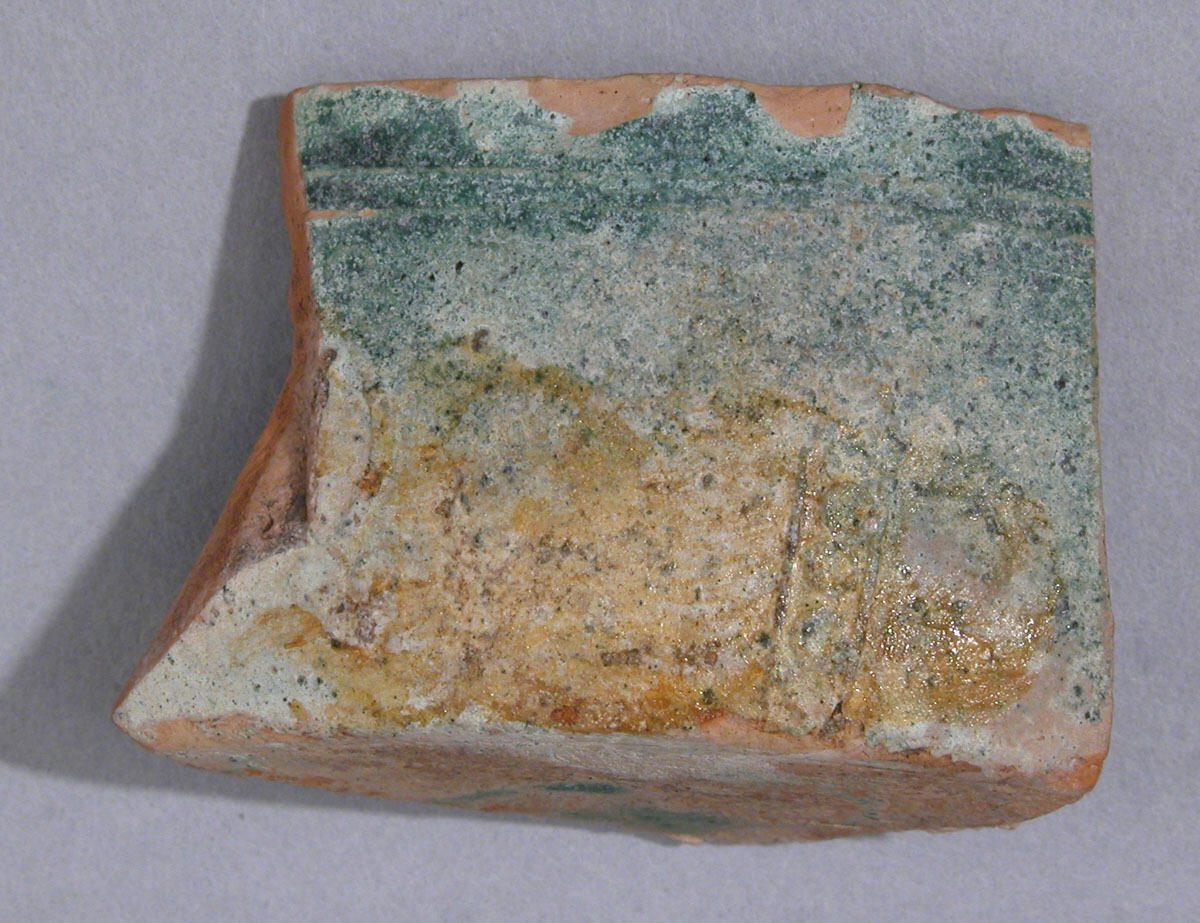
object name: fragment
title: Ceramic Fragment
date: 801-900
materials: earthenware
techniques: glazing, molding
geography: saudi arabia